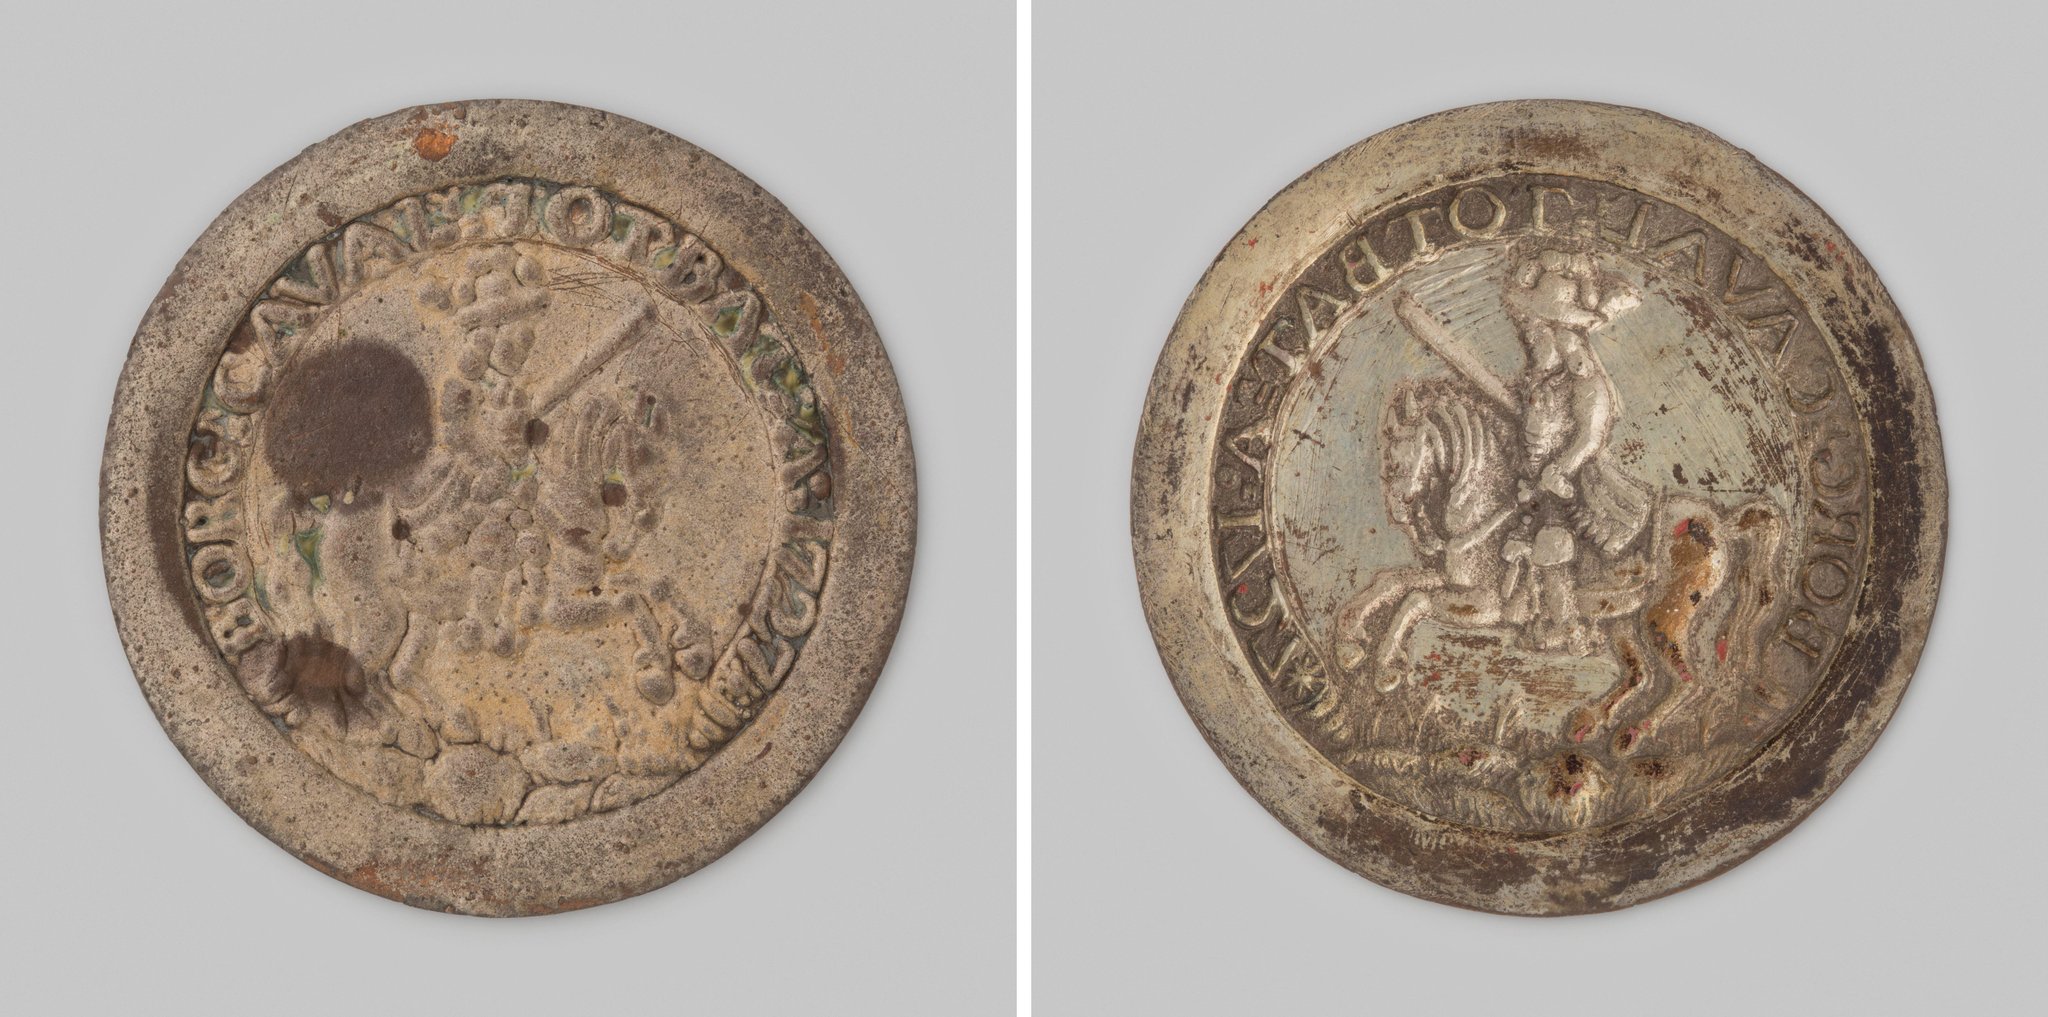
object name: history medal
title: Erepenning voor de Borger Cavalerie te Batavia (voorzijde) 1727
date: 1727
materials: copper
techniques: galvanoplasty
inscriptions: circumscription: ‘BORG'-CAVAL' TOT BAT' A° 1727’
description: Verzilverde galvanoplastische afdruk van de voorzijde van de penning, een ruiter naar rechts met omschrift.